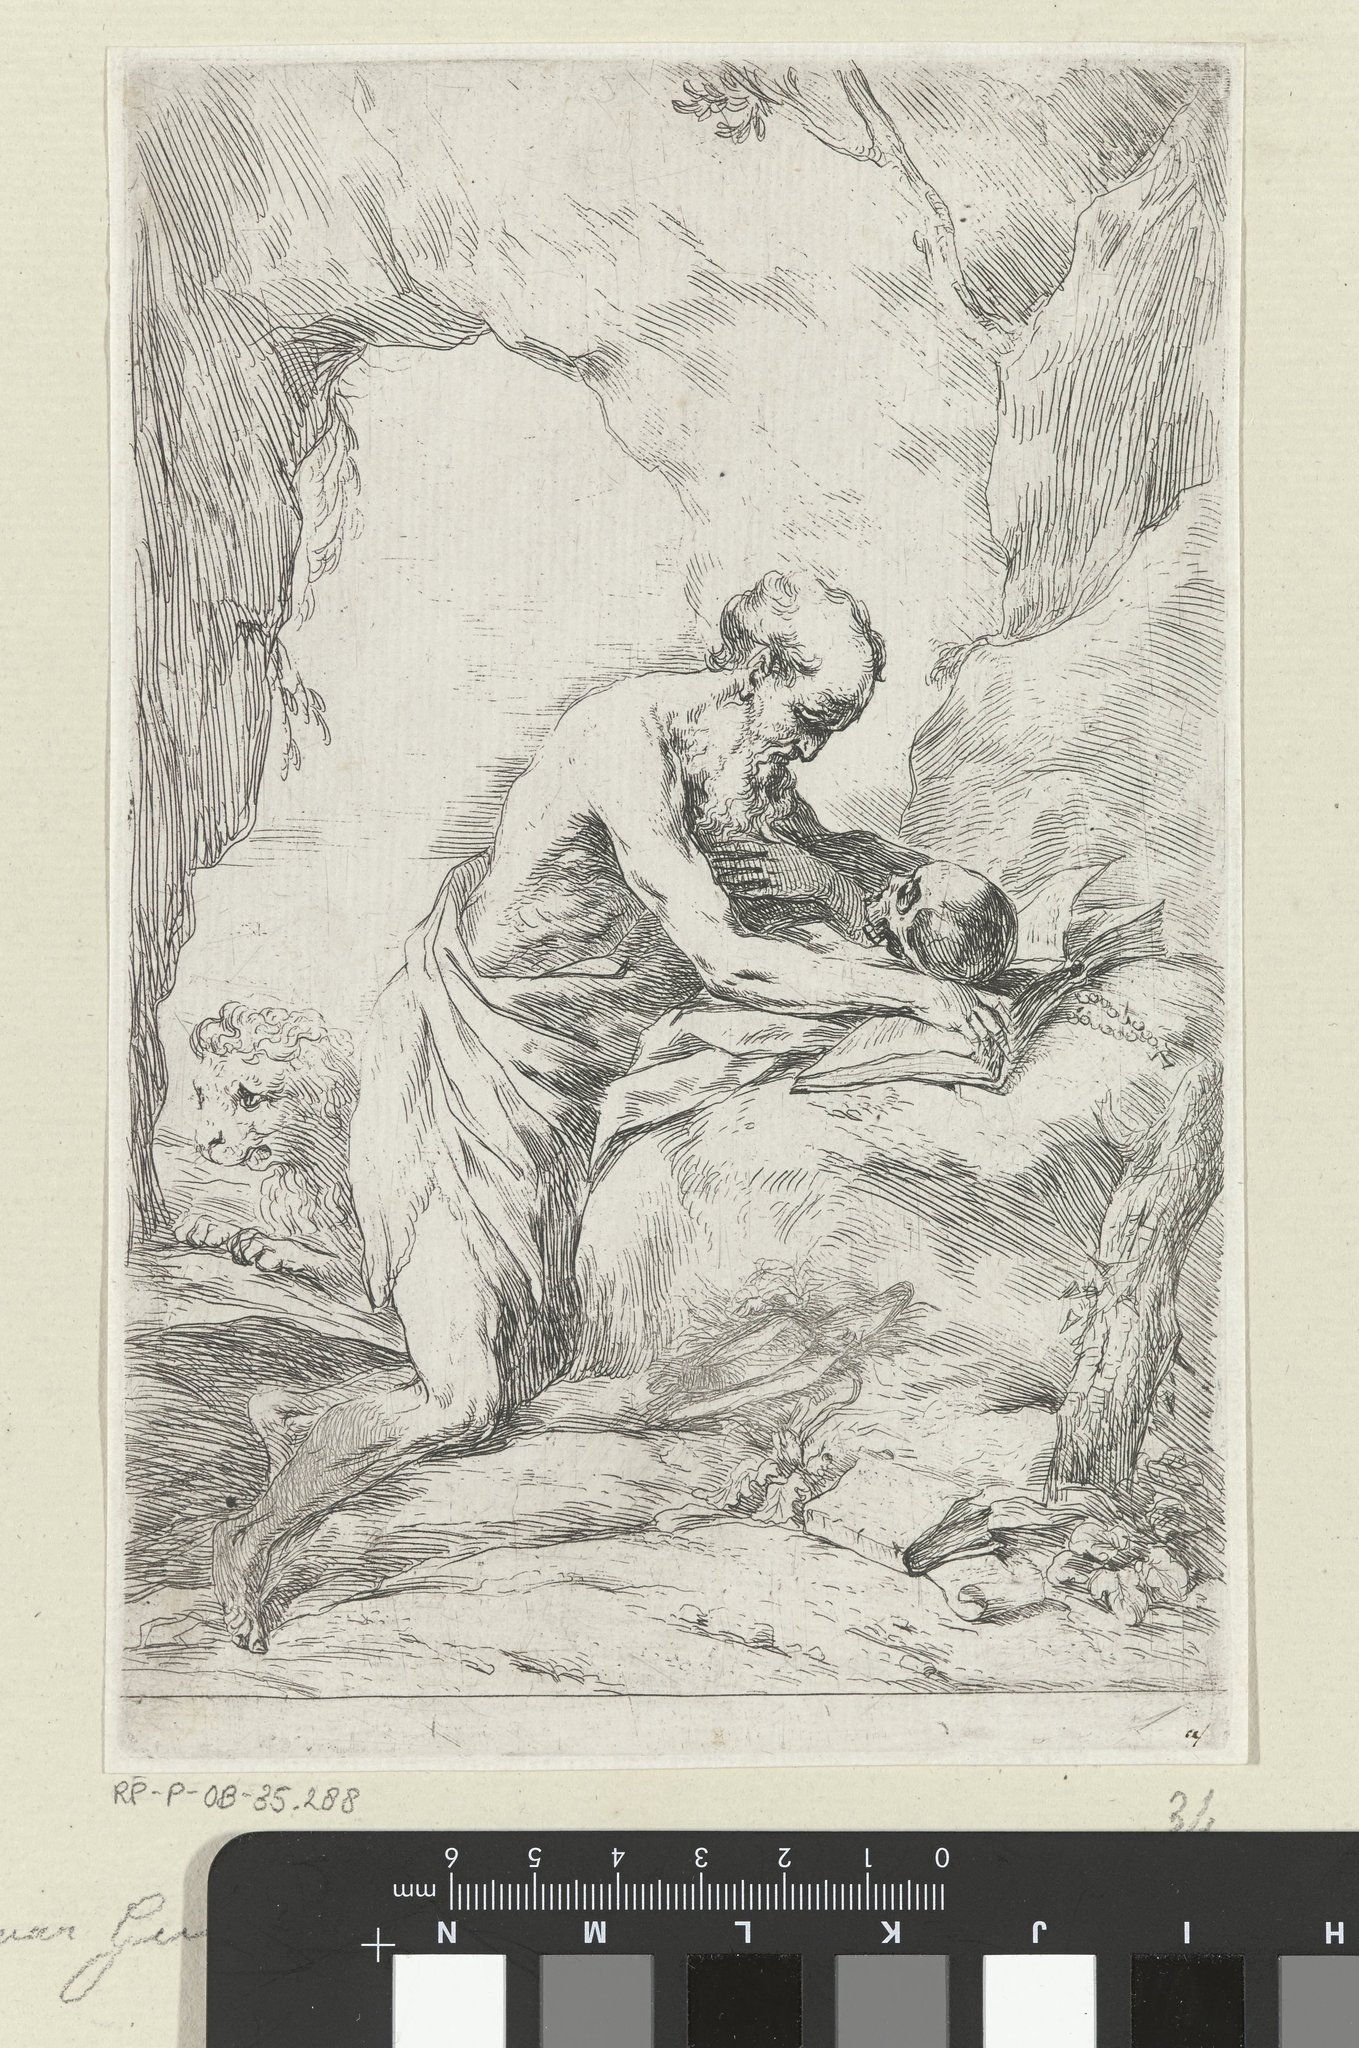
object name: print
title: Hieronymus lezend in de wildernis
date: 1642-1657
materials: paper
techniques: etching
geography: italy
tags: the monk and hermit jerome (hieronymus); possible attributes: book, cardinal's hat, crucifix, hour-glass, lion, skull, stone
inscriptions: collector's mark: Lugt 240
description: De heilige Hieronymus leest een boek in de wildernis. Op het boek ligt een schedel. Achter Hieronymus ligt een leeuw.